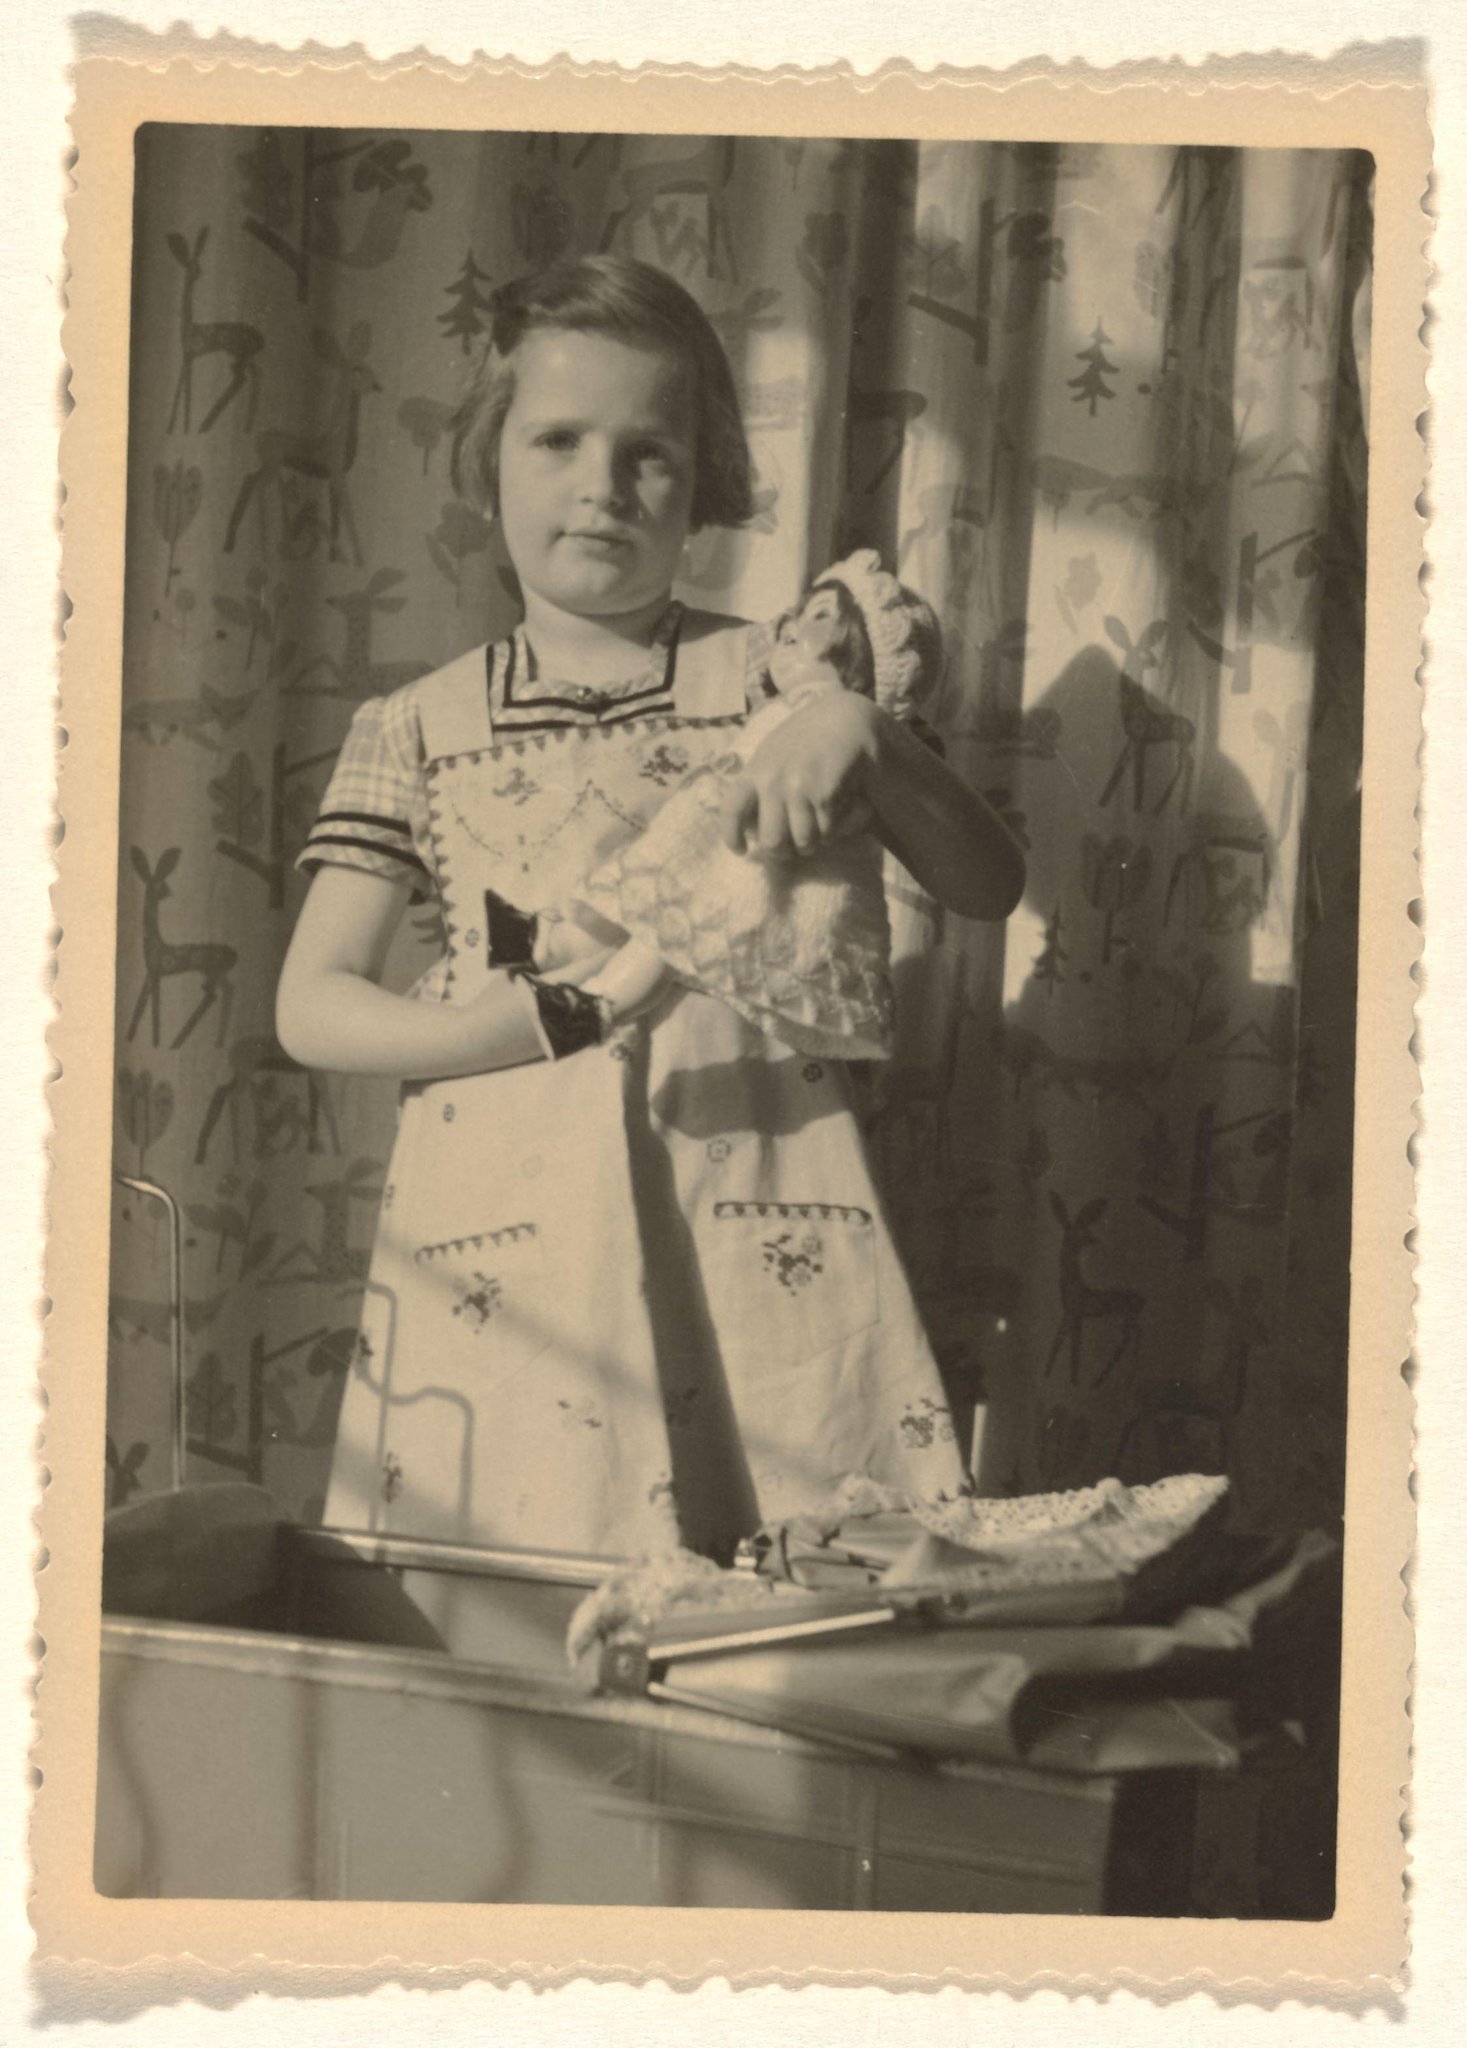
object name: photograph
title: Isabel Wachenheimer voor een kinderwagen en met een pop in haar armen, april-mei 1935, Stuttgart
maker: Anonymous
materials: photographic support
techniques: gelatin silver print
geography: stuttgart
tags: leiden, isabel wachenheimer-elon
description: Isabel Wachenheimer voor een kinderwagen en met een pop in haar armen.